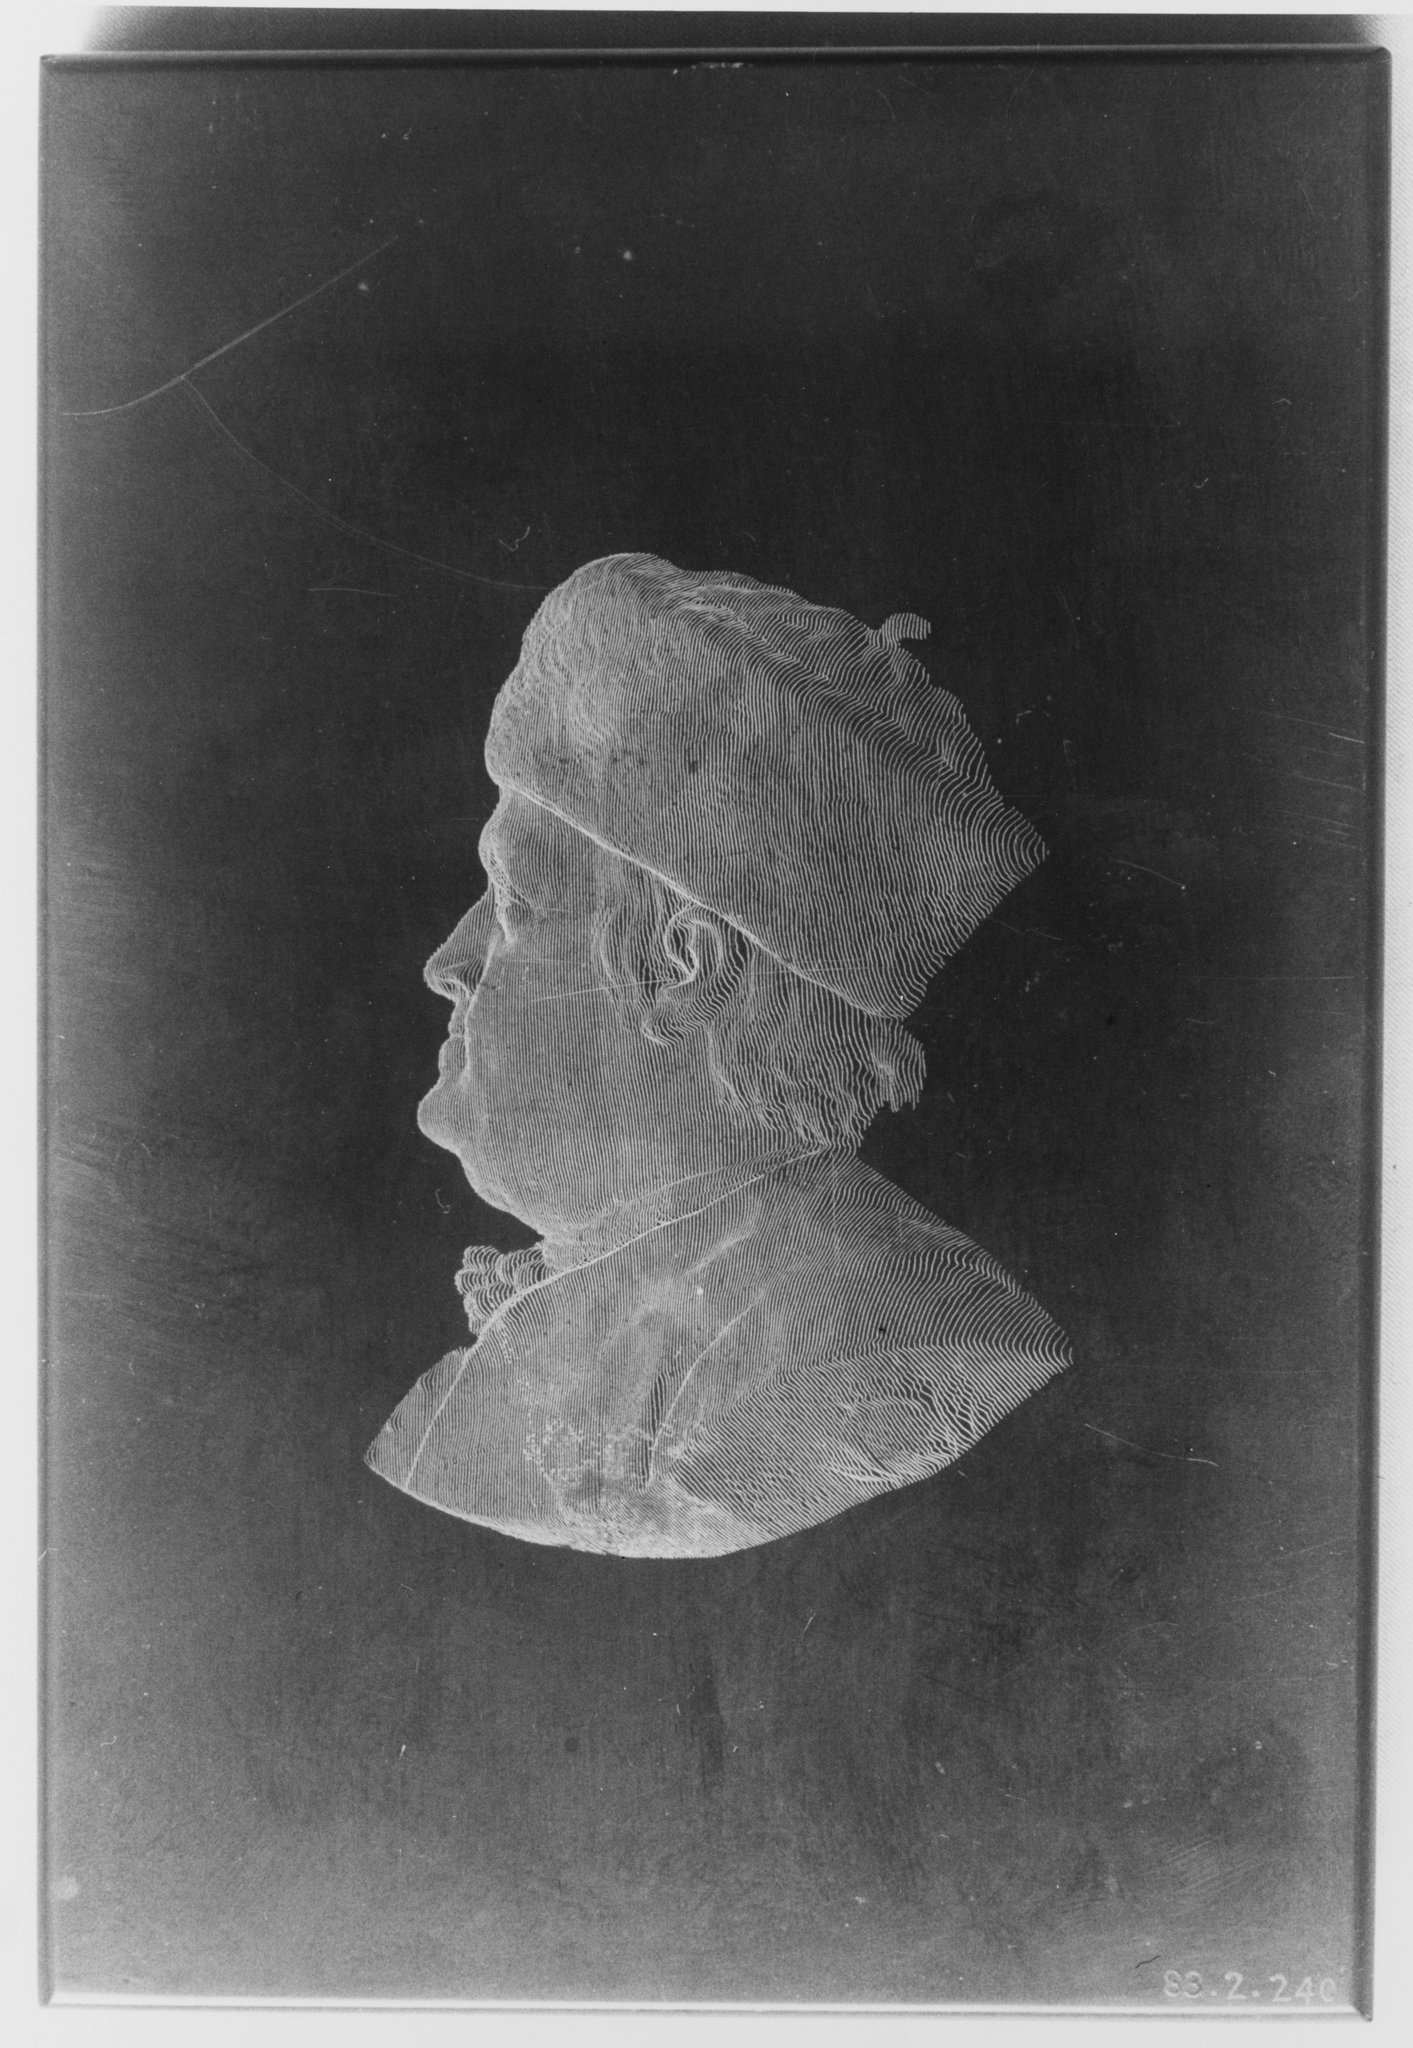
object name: bust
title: Portrait of Benjamin Franklin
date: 1800-1883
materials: stone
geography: france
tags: benjamin franklin,profiles